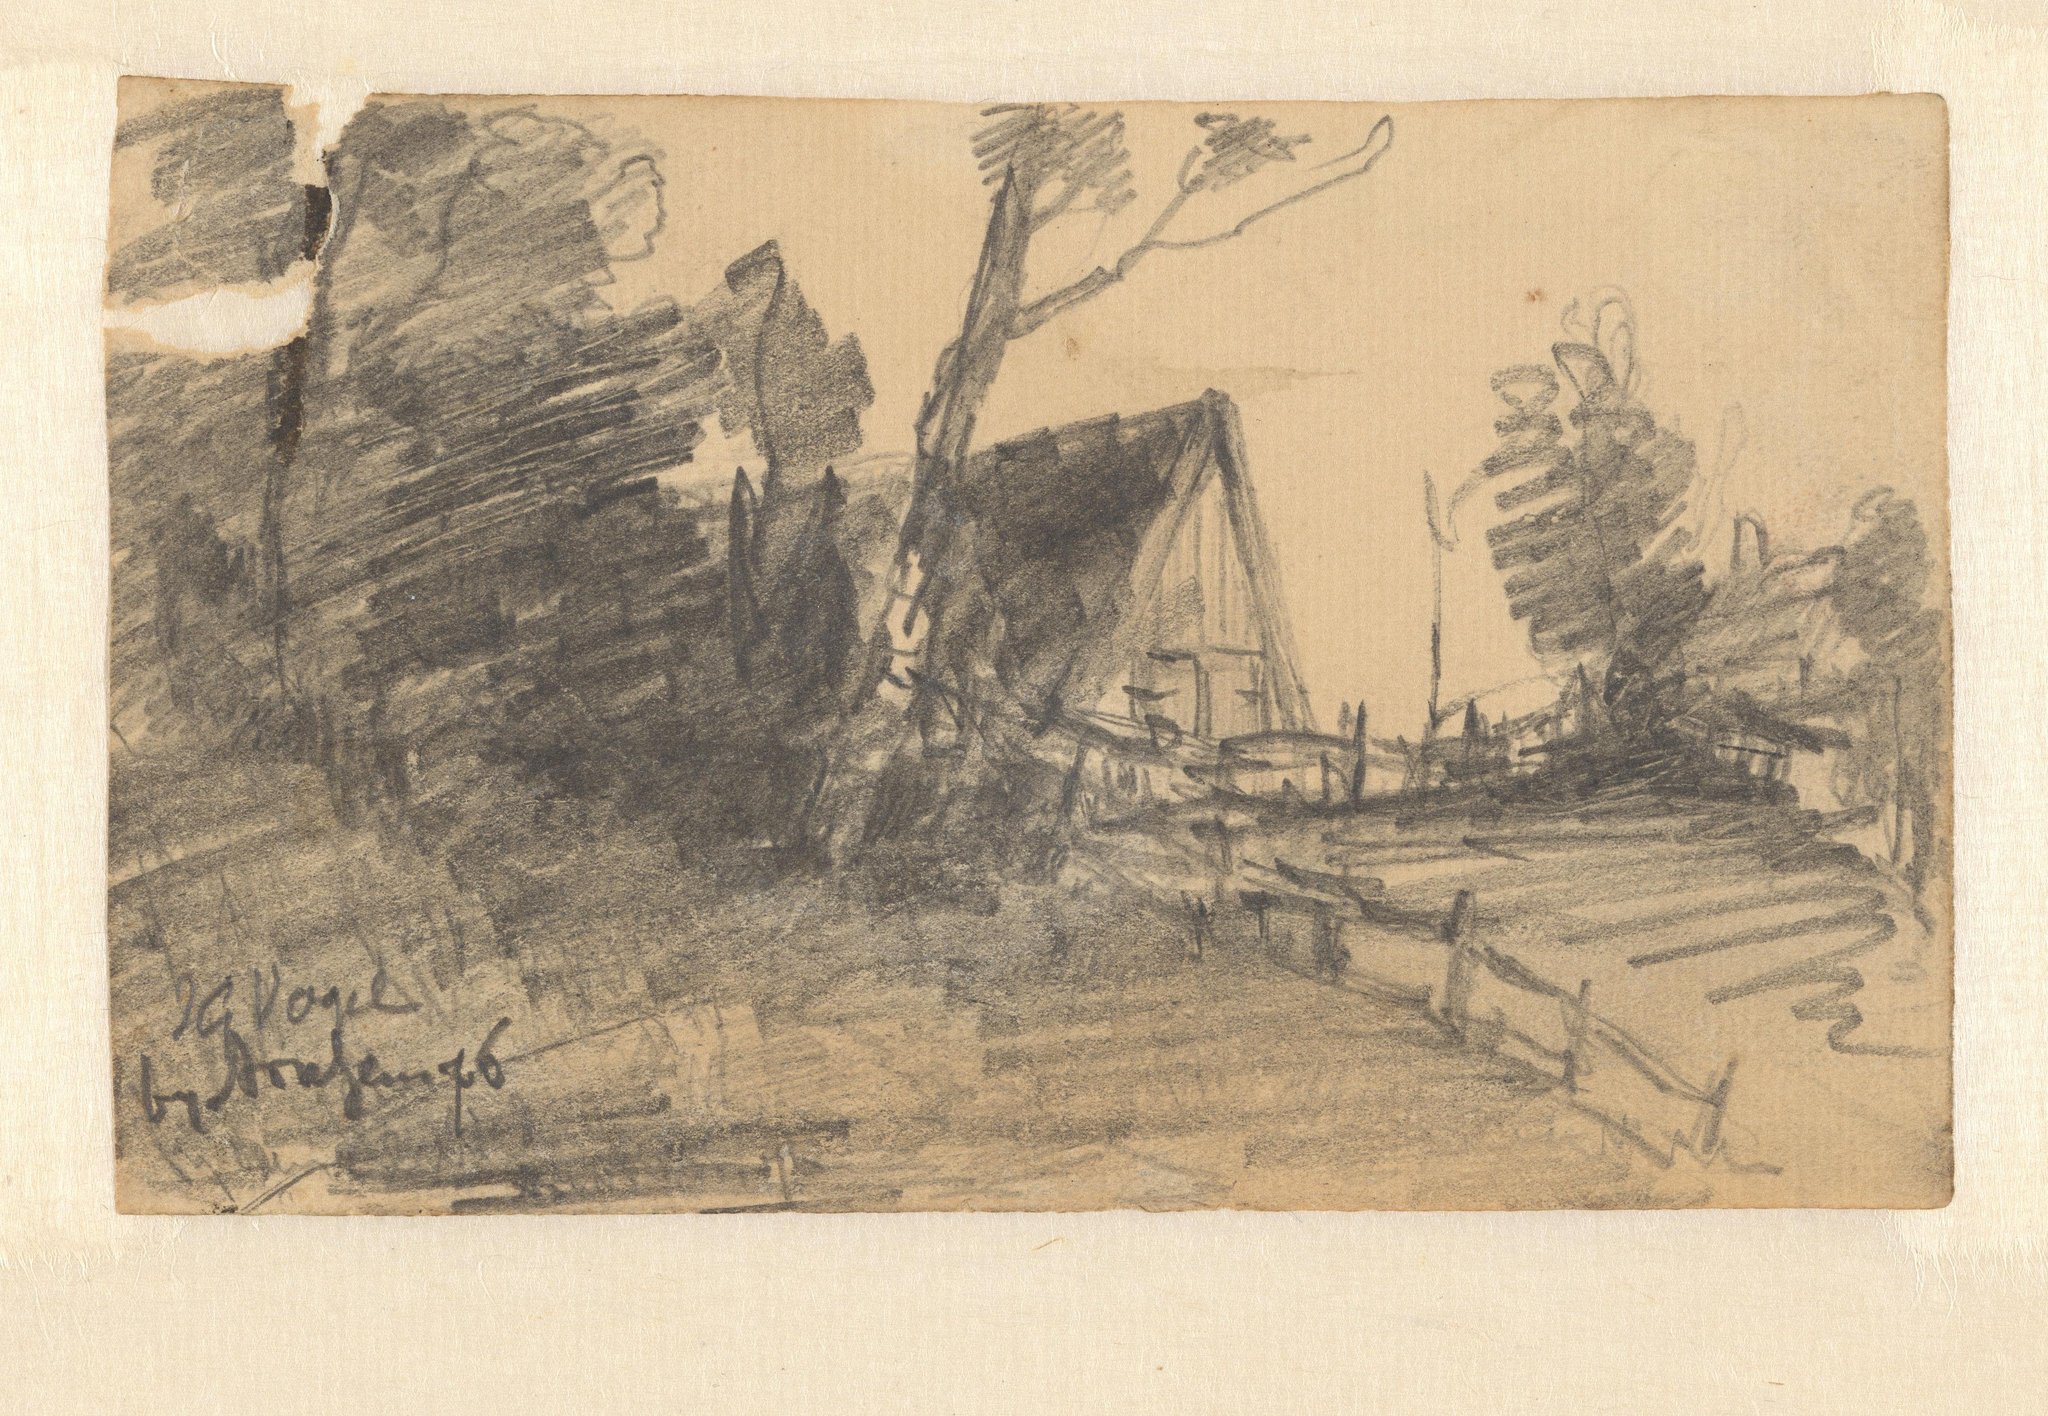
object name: drawing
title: Boerderij in een landschap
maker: johannes gijsbert vogel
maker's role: draughtsman, painter, print maker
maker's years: 1828-1915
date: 1876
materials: paper, pencil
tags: farm or solitary house in landscape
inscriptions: collector's mark: Lugt 1181b, date and inscription: ‘bij sou[...]e[...] 76’